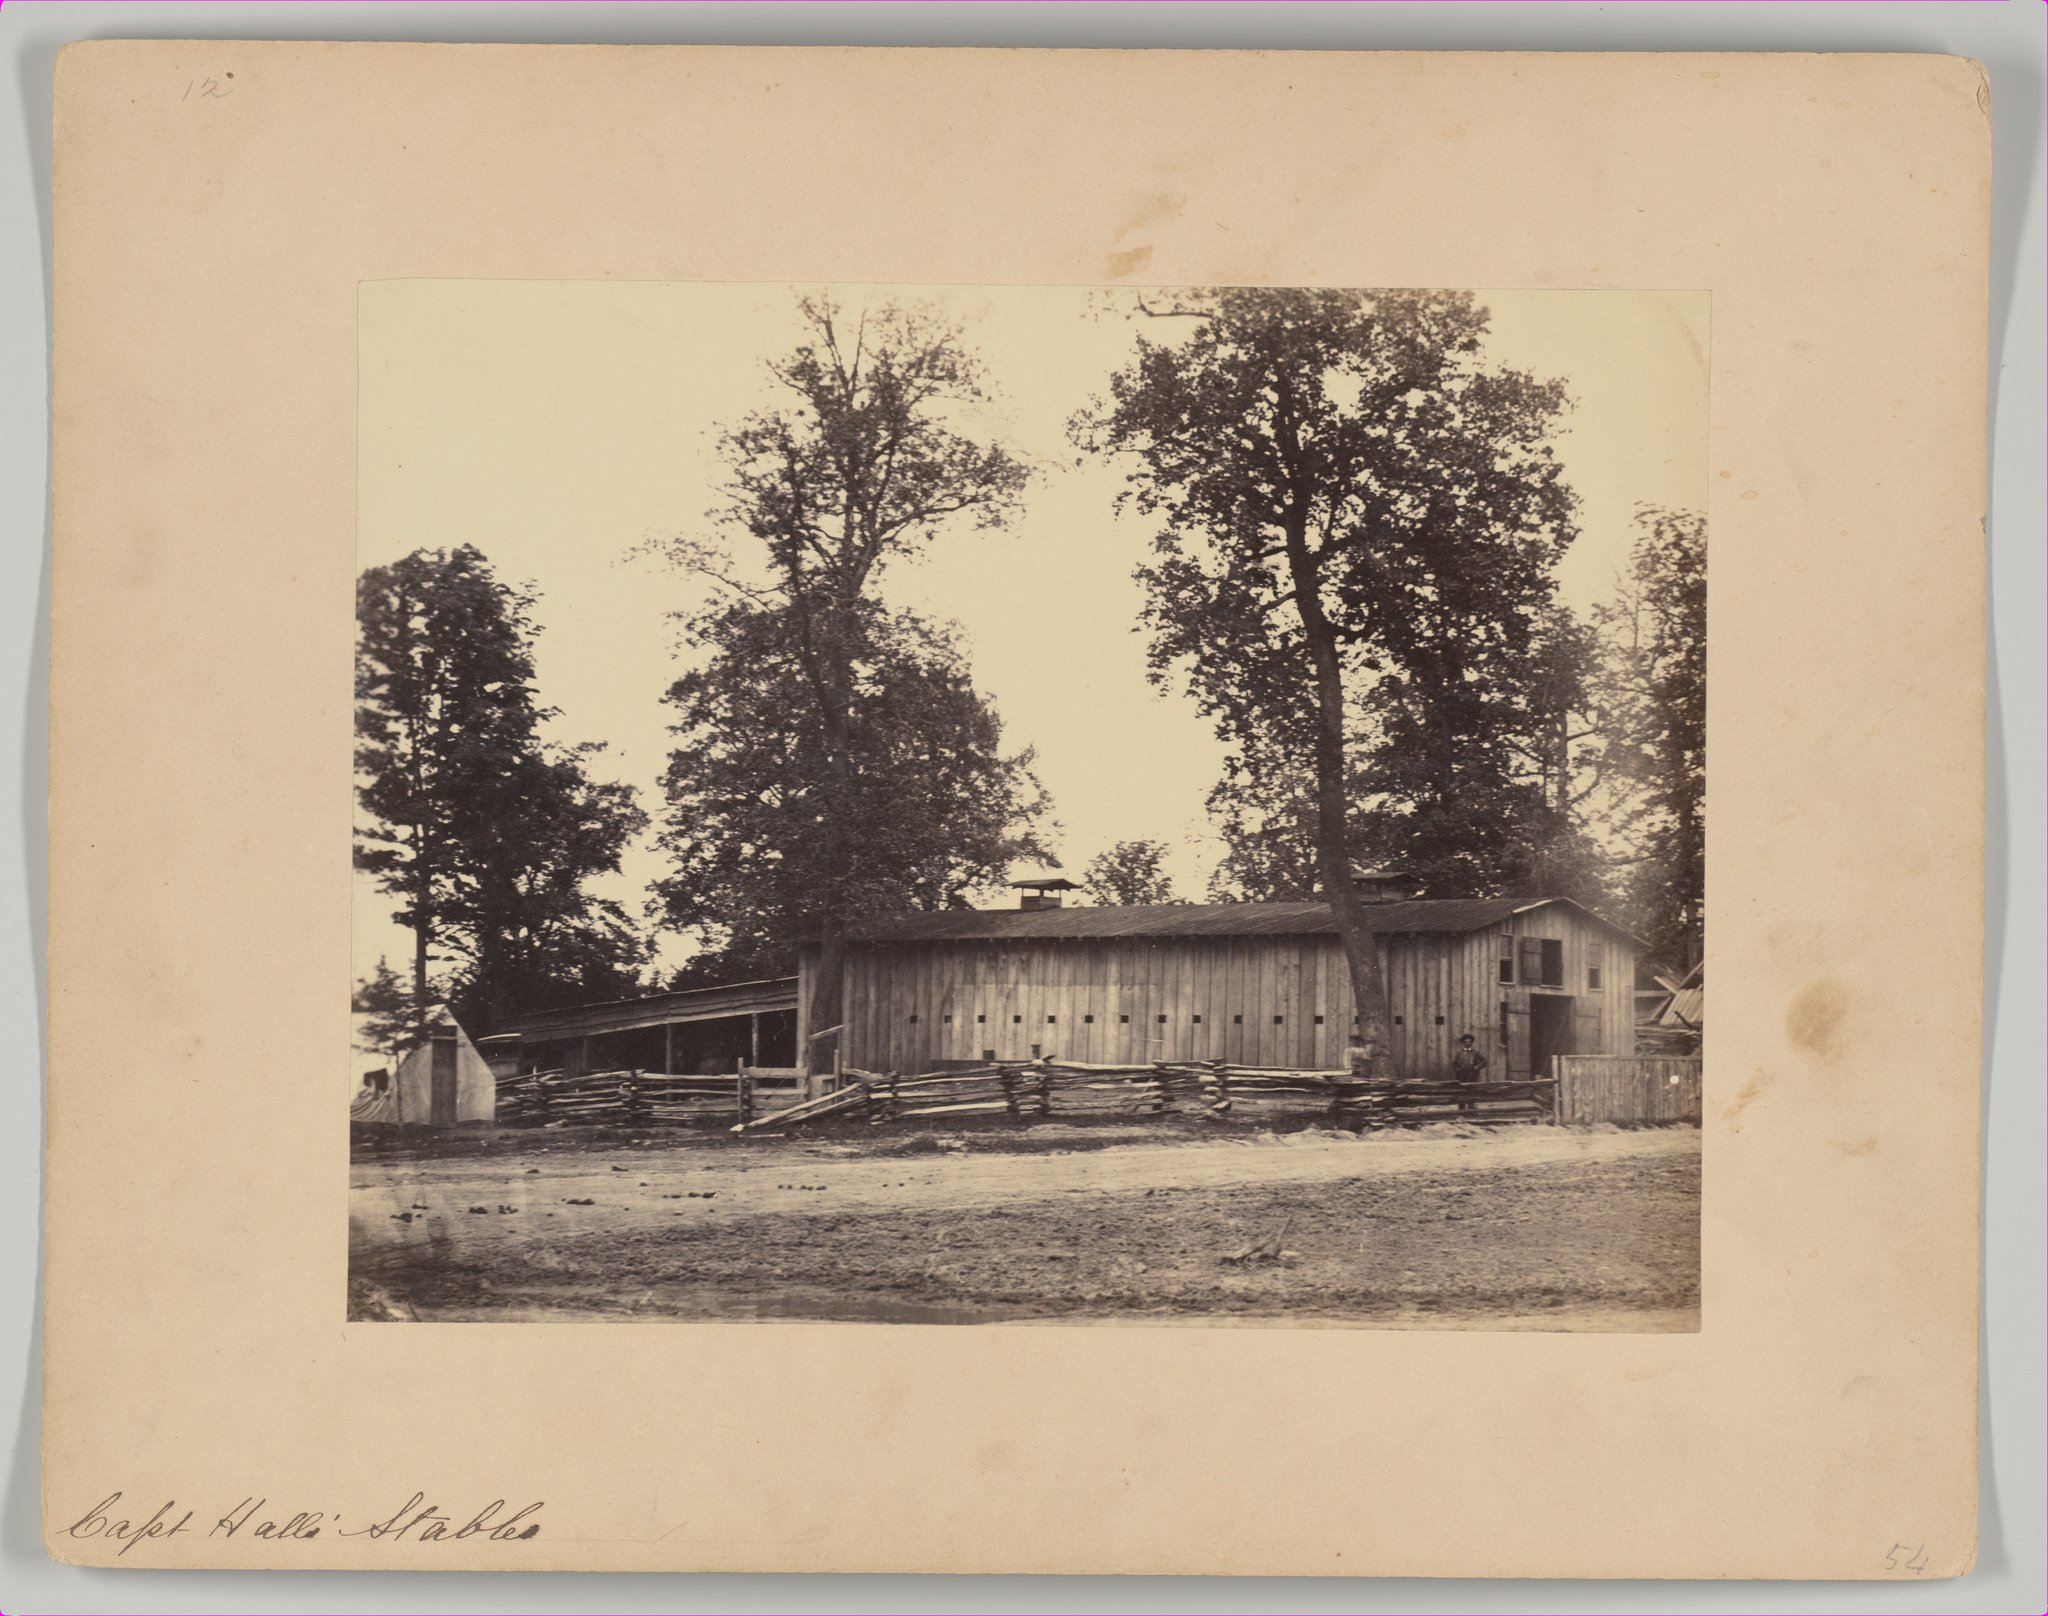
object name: photograph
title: Capt. Hall’s Stables, Camp Nelson, Kentucky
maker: g. w. foster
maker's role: artist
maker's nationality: american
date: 1863-1864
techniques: albumen silver print, glass negative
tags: american civil war